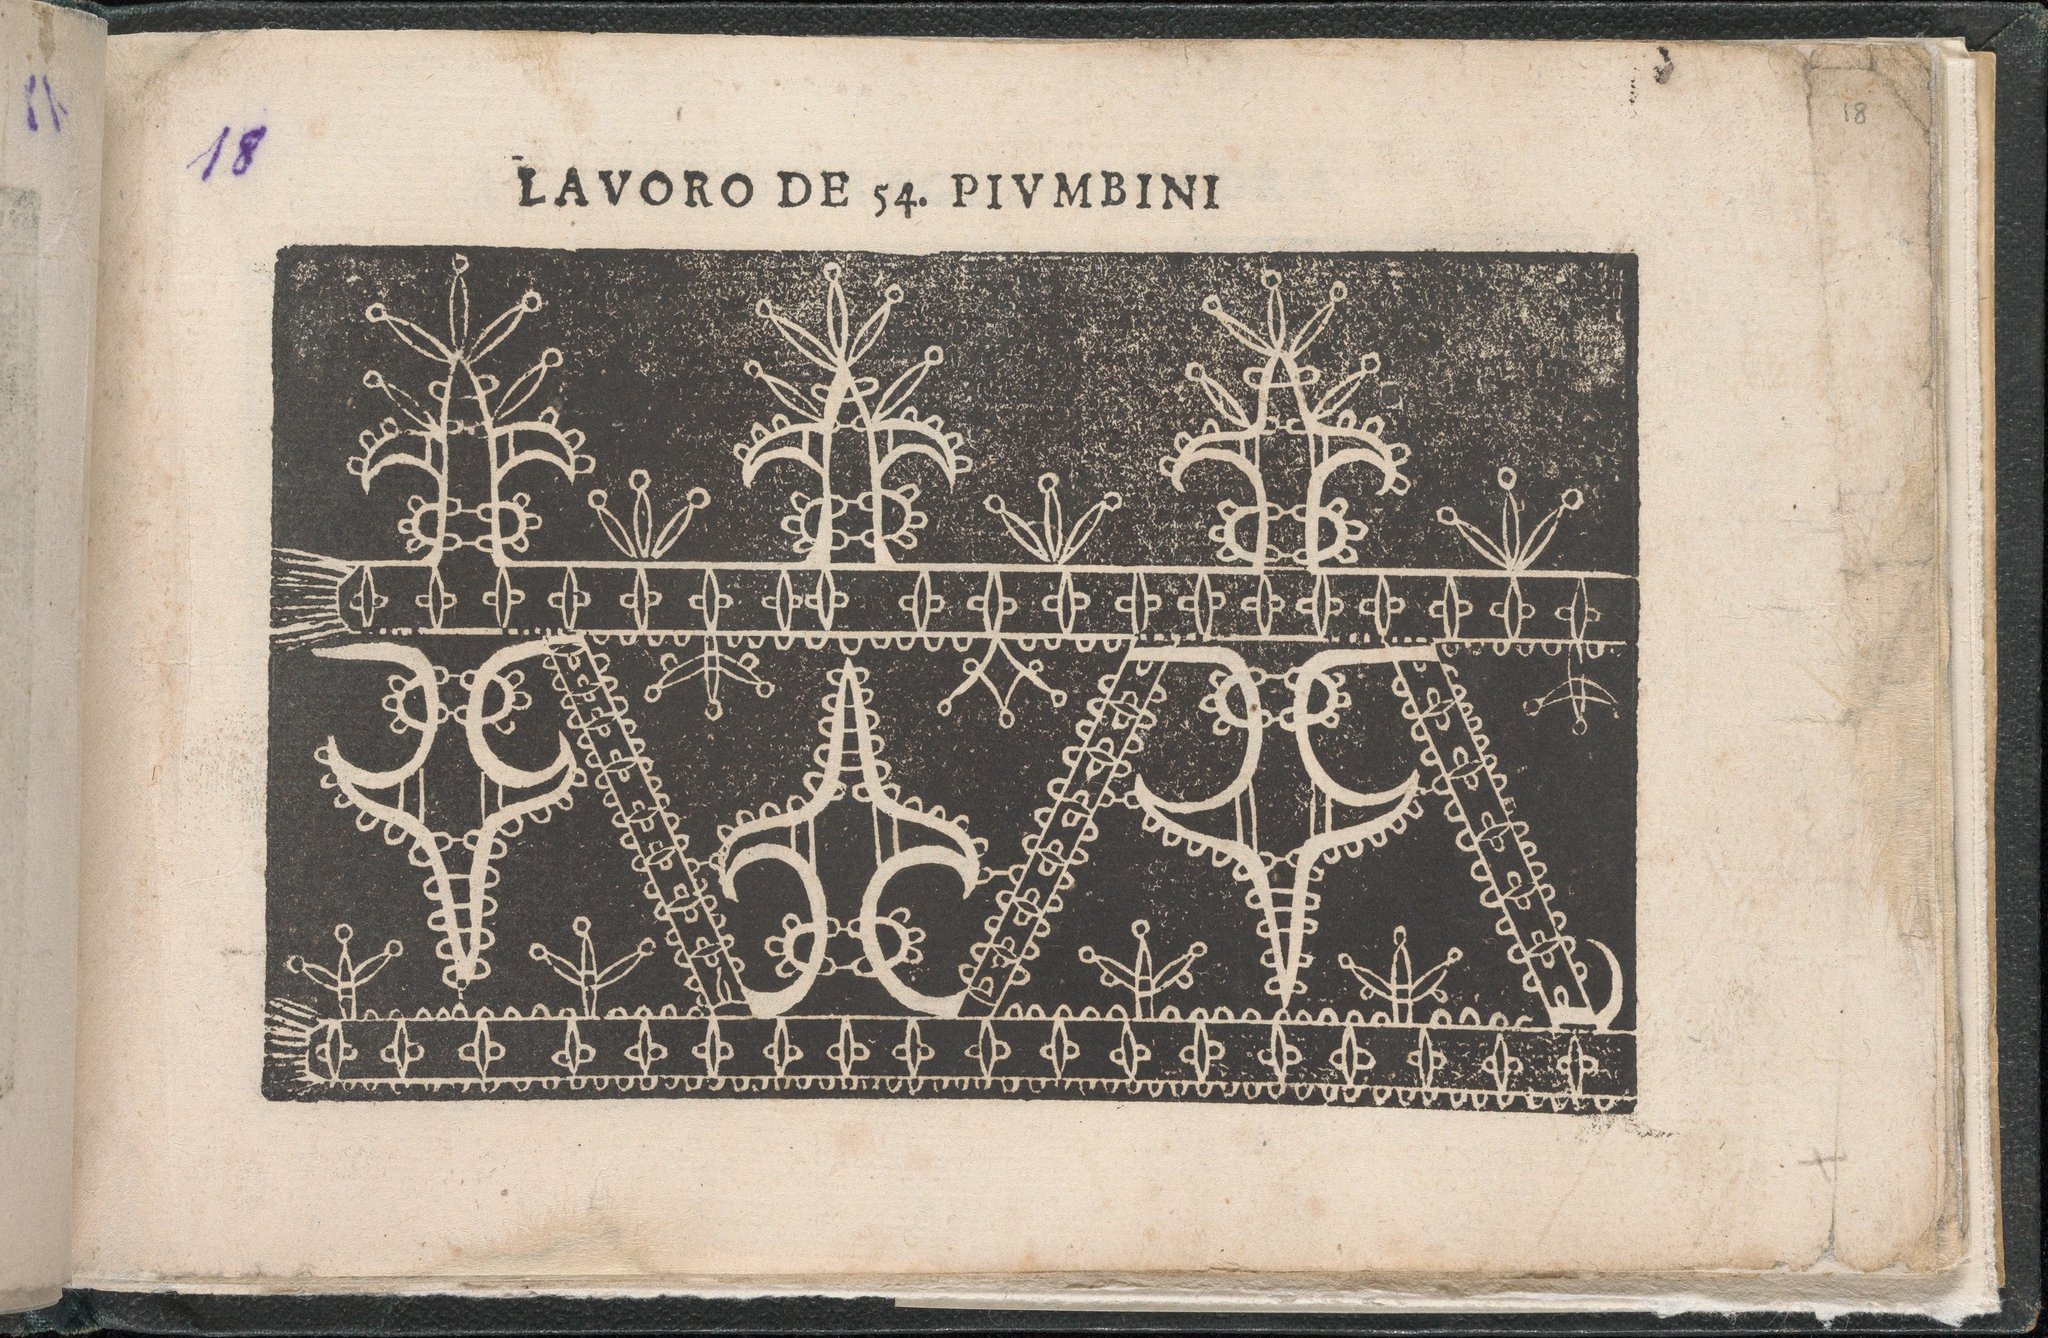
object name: book print ornament architecture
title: Gemma pretiosa della virtuose donne, page 18 (recto)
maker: isabella catanea parasole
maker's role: designer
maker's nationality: italian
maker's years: 1565-1625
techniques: woodcut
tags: ornament